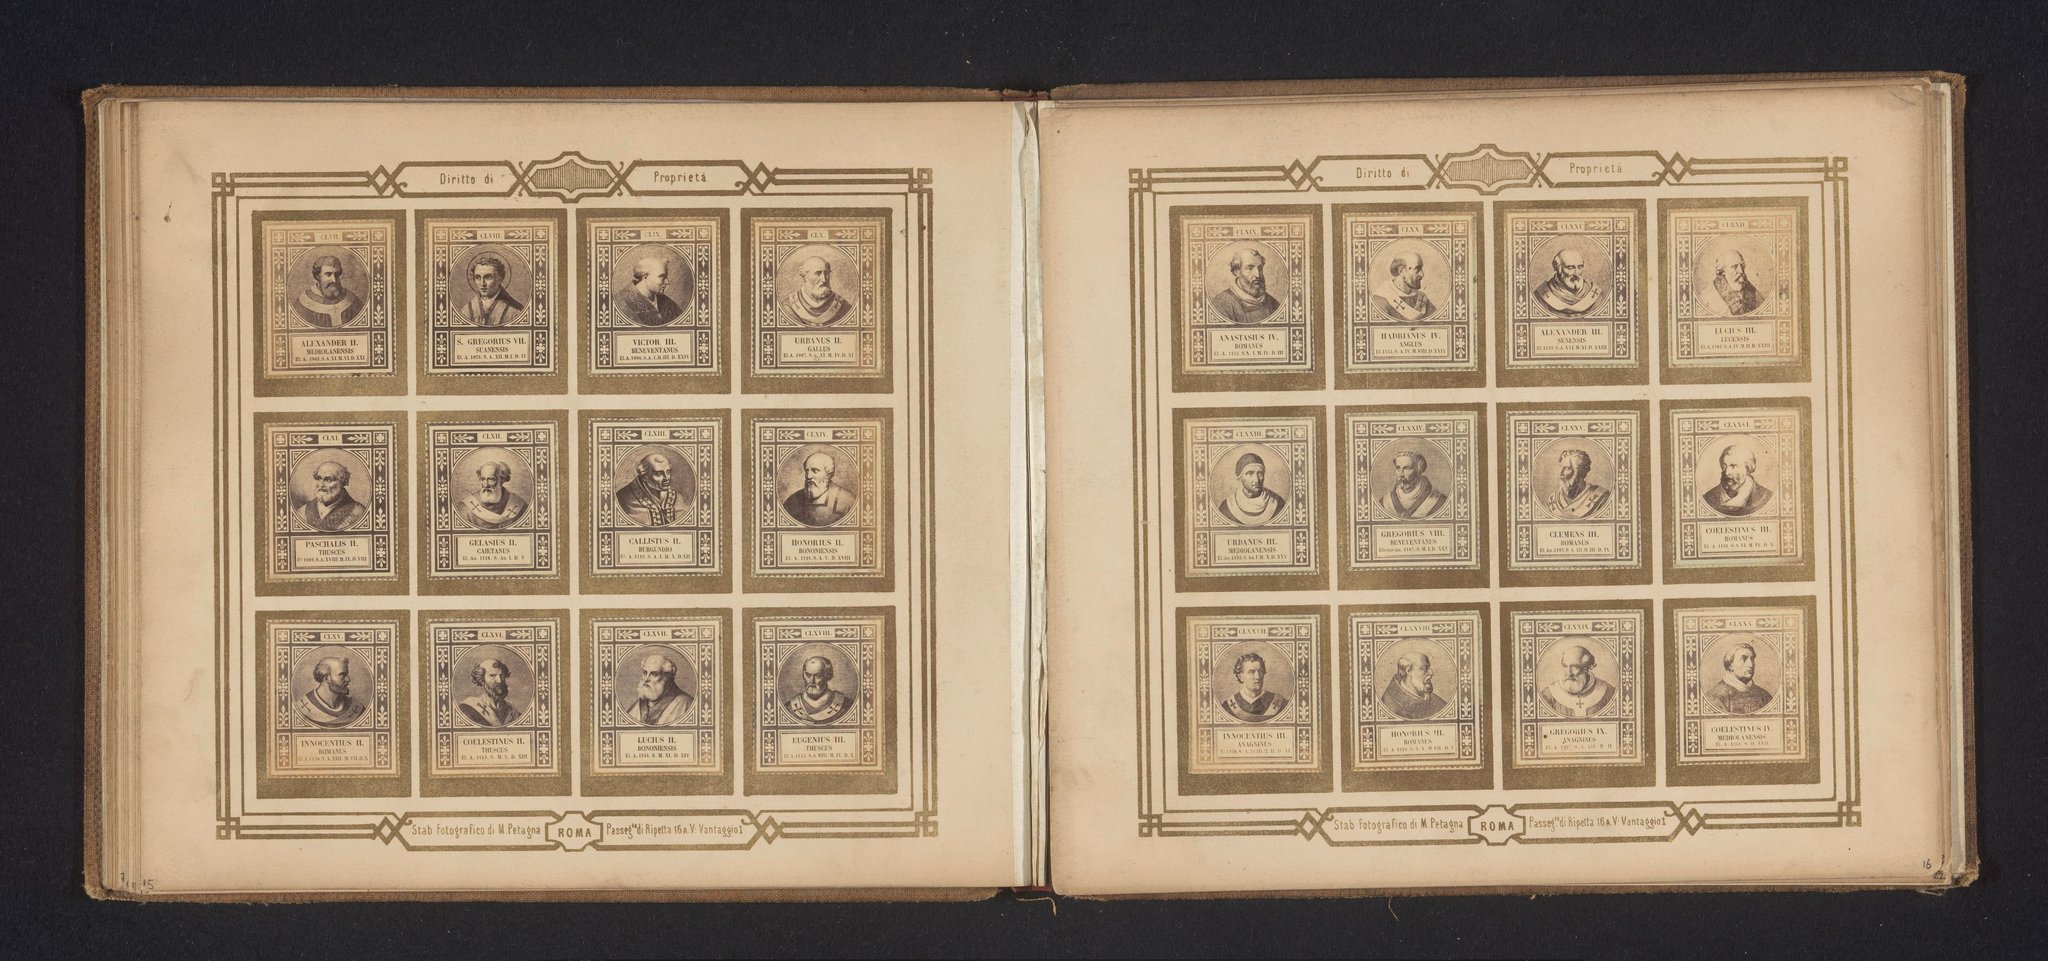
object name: photograph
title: Fotoreproductie van twaalf portretten van pausen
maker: m. petagna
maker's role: fotograaf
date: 1854-1864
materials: photographic support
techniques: albumen print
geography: rome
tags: pope